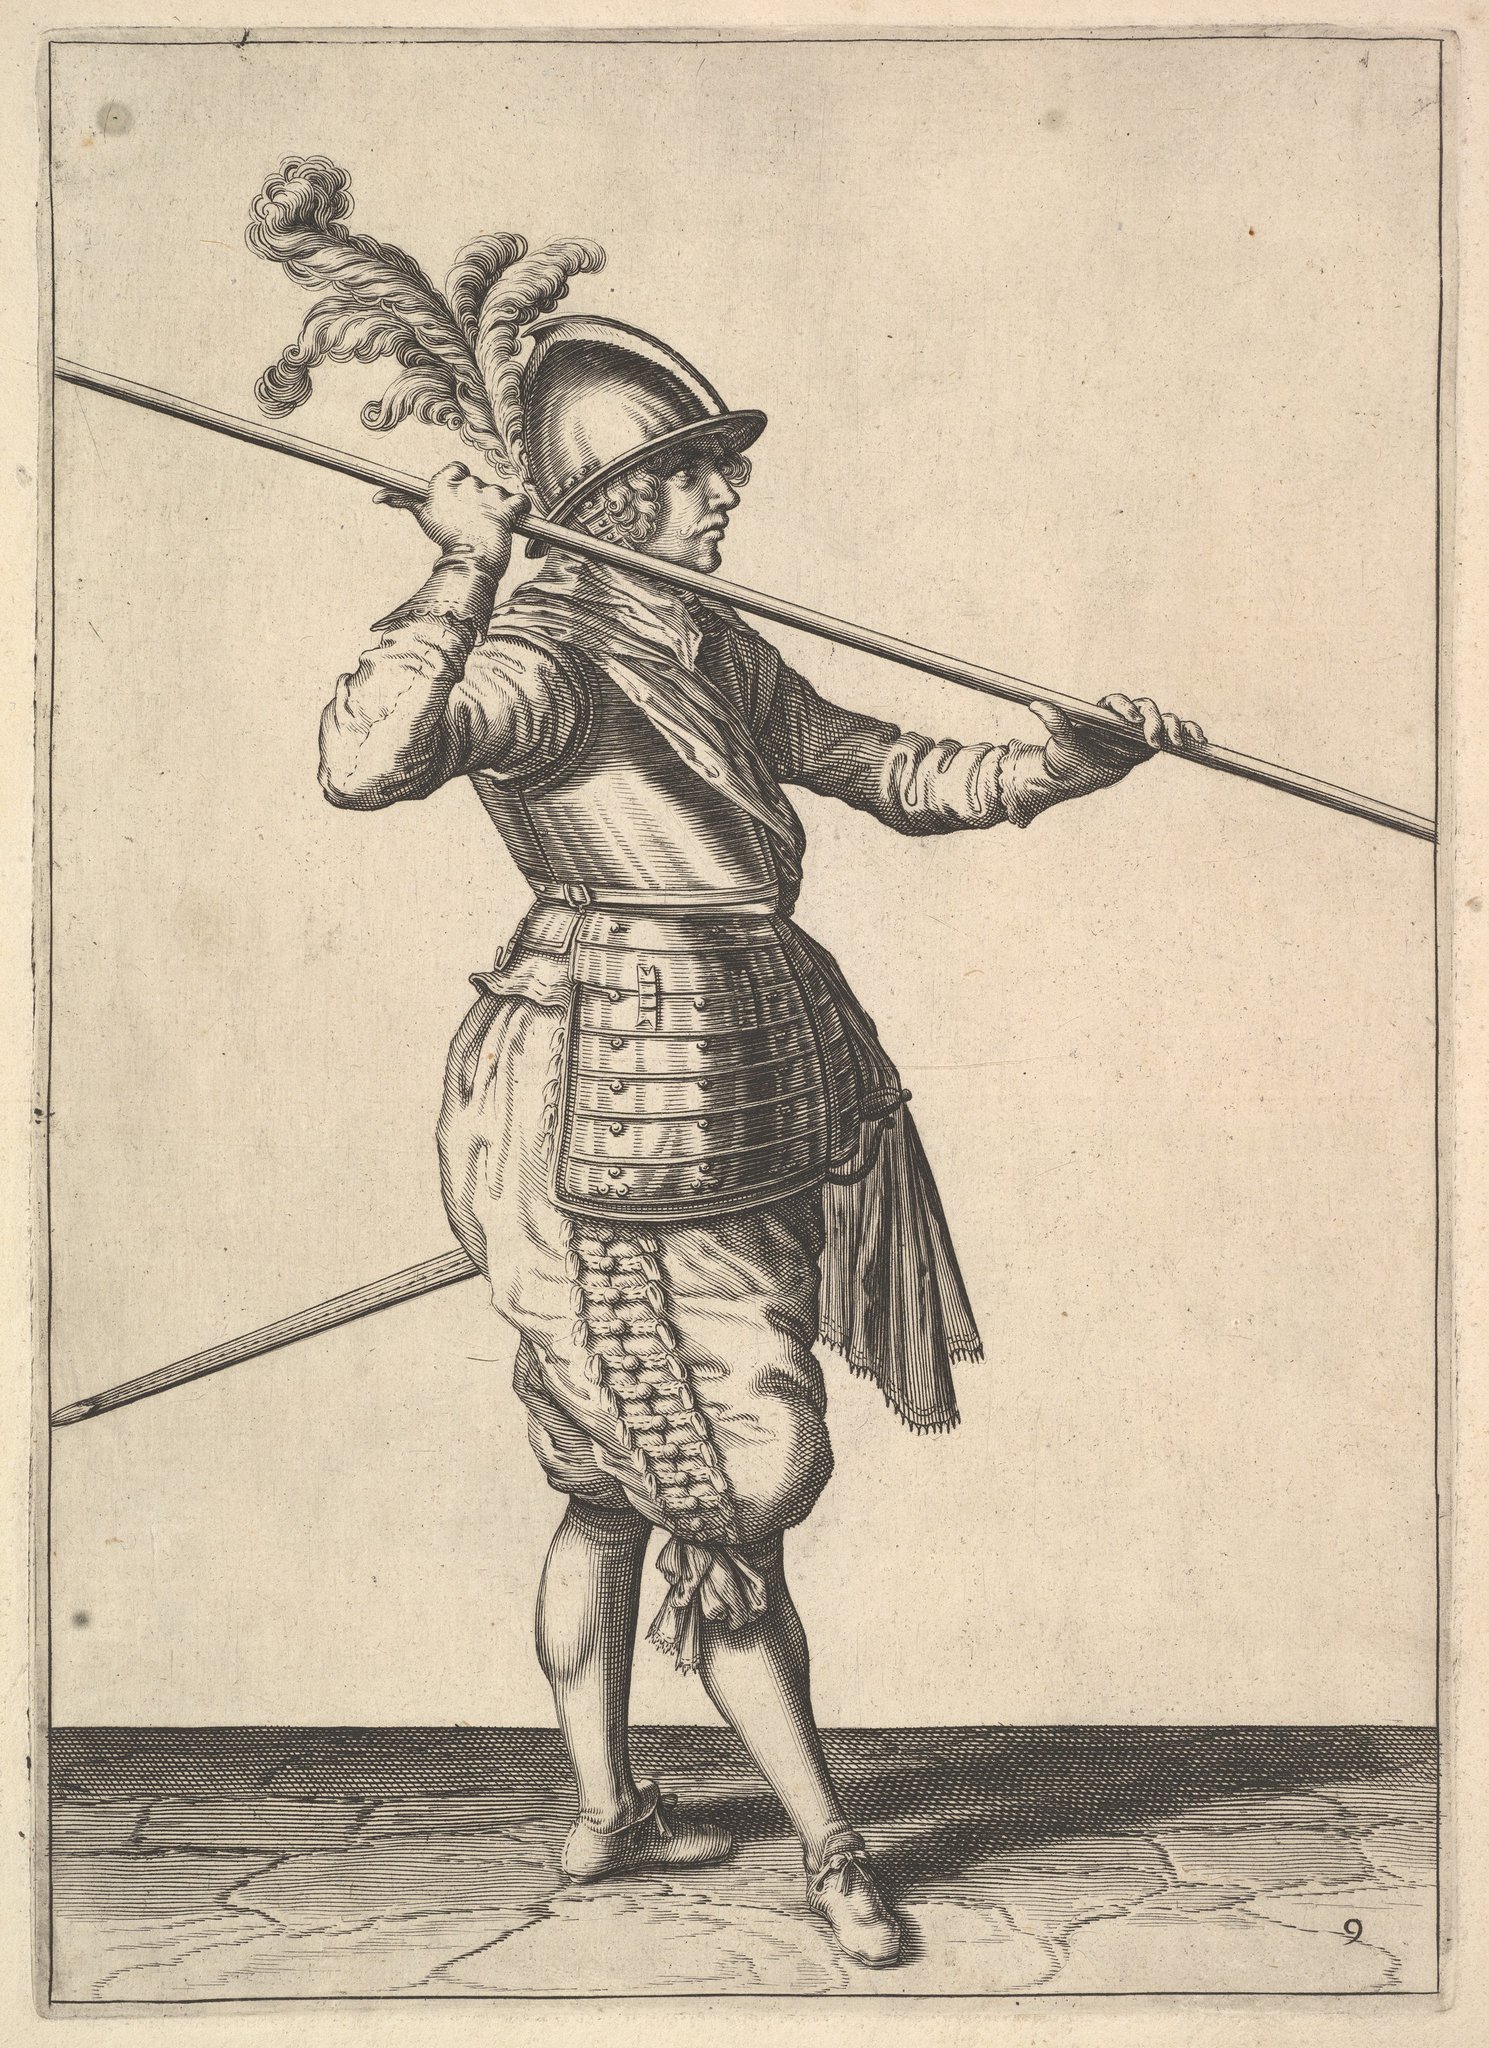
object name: print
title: The second movement for bringing the pike on to the shoulder and holding it horizontally, from the Lansquenet series, plate 9, in "Wapenhandelinghe van Roers Musquetten Ende Spiessen" (The Exercise of Arms)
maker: jacques de gheyn (ii)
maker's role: artist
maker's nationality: netherlandish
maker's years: 1565-1629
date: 1575-1629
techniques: engraving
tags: soldiers,weapons